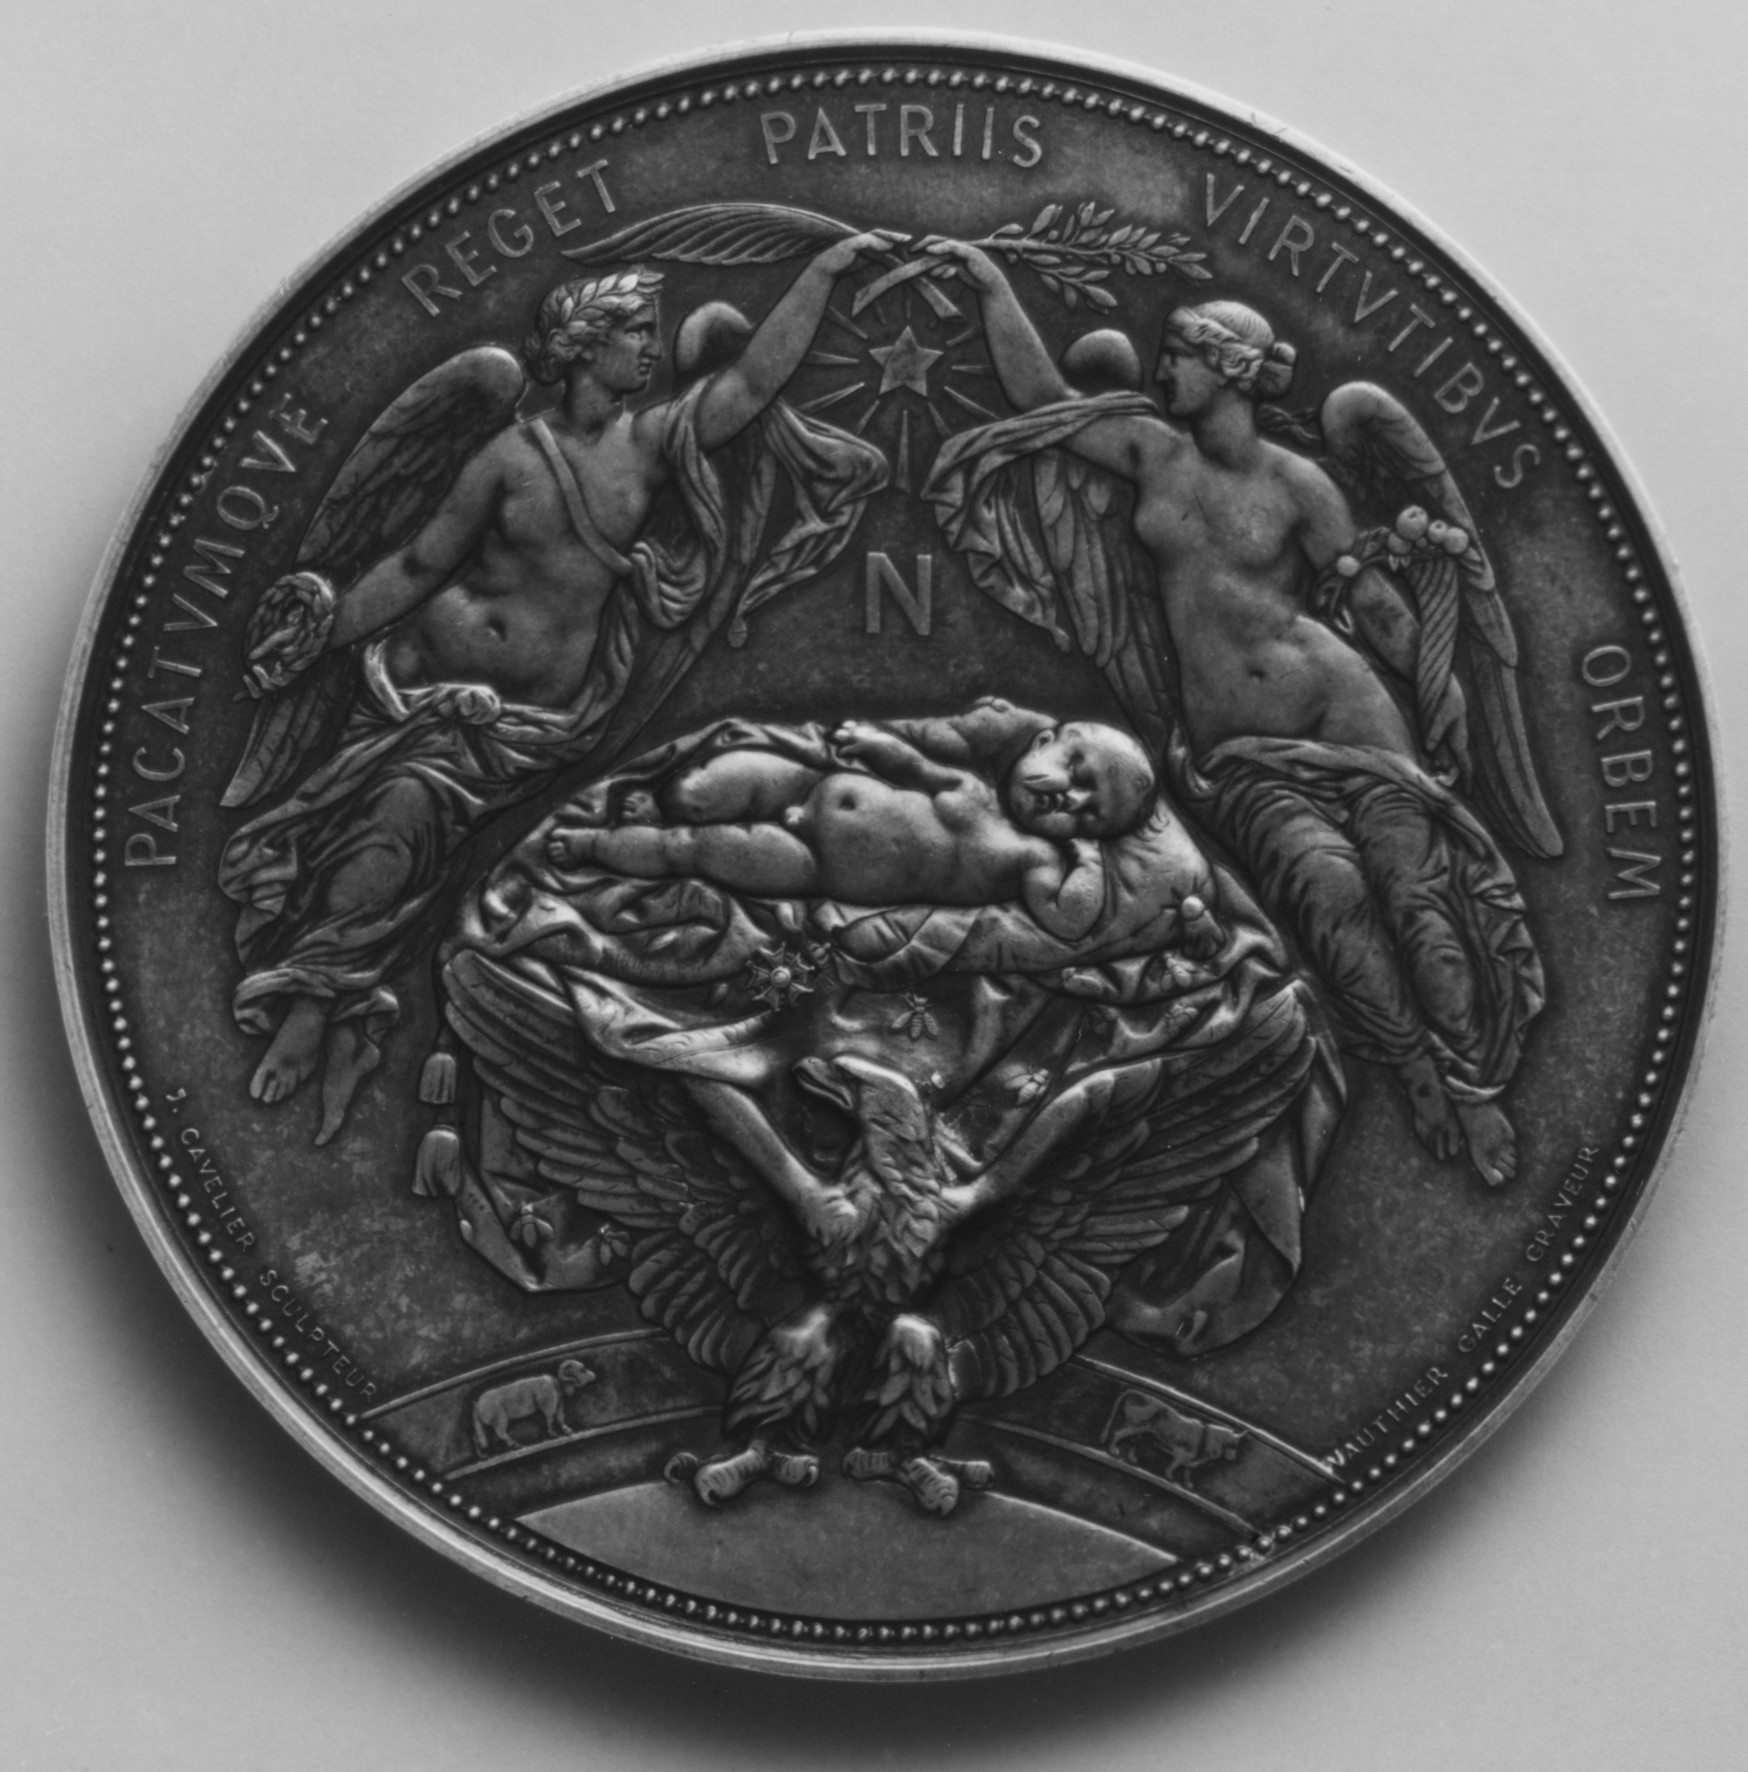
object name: medal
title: Cradle of the Prince Imperial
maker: pierre-jules cavelier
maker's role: artist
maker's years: 1814-1896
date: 1856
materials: bronze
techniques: struck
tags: eagles,infants,cradles